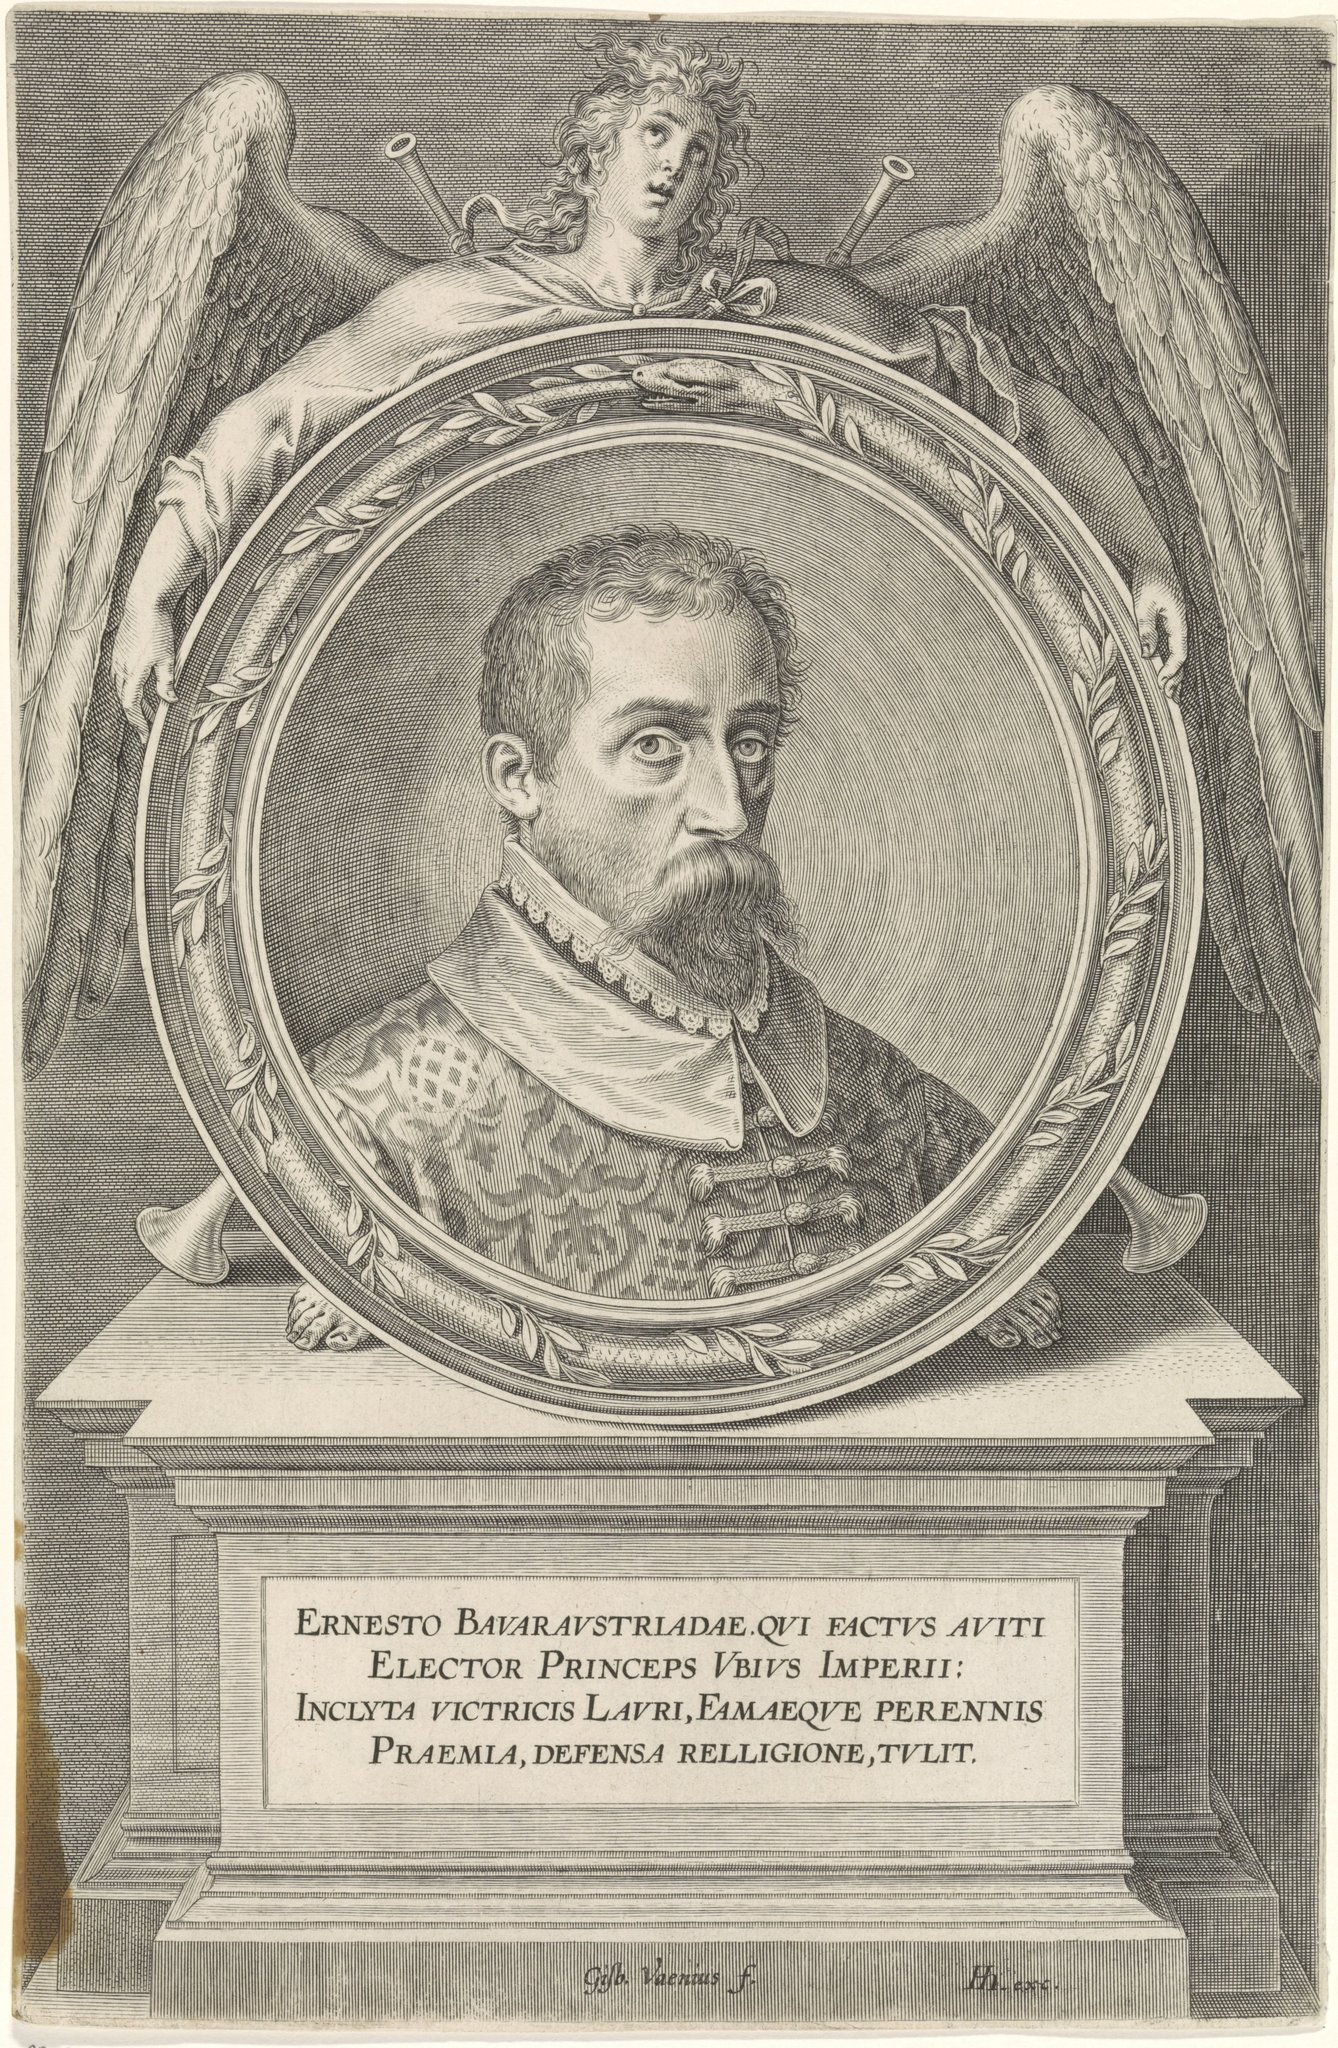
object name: print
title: Portret van Ernst van Beieren, prins-bisschop van Luik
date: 1583-1650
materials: paper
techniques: engraving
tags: ernst van beieren (prins-bisschop van luik), fame; 'fama', 'fama buona', 'fama chiara' (ripa)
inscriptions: collector's mark: Lugt 2228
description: Ernst, Ernst van Beieren, prins-bisschop van Luik, in een medaillon vastgehouden door Fama.